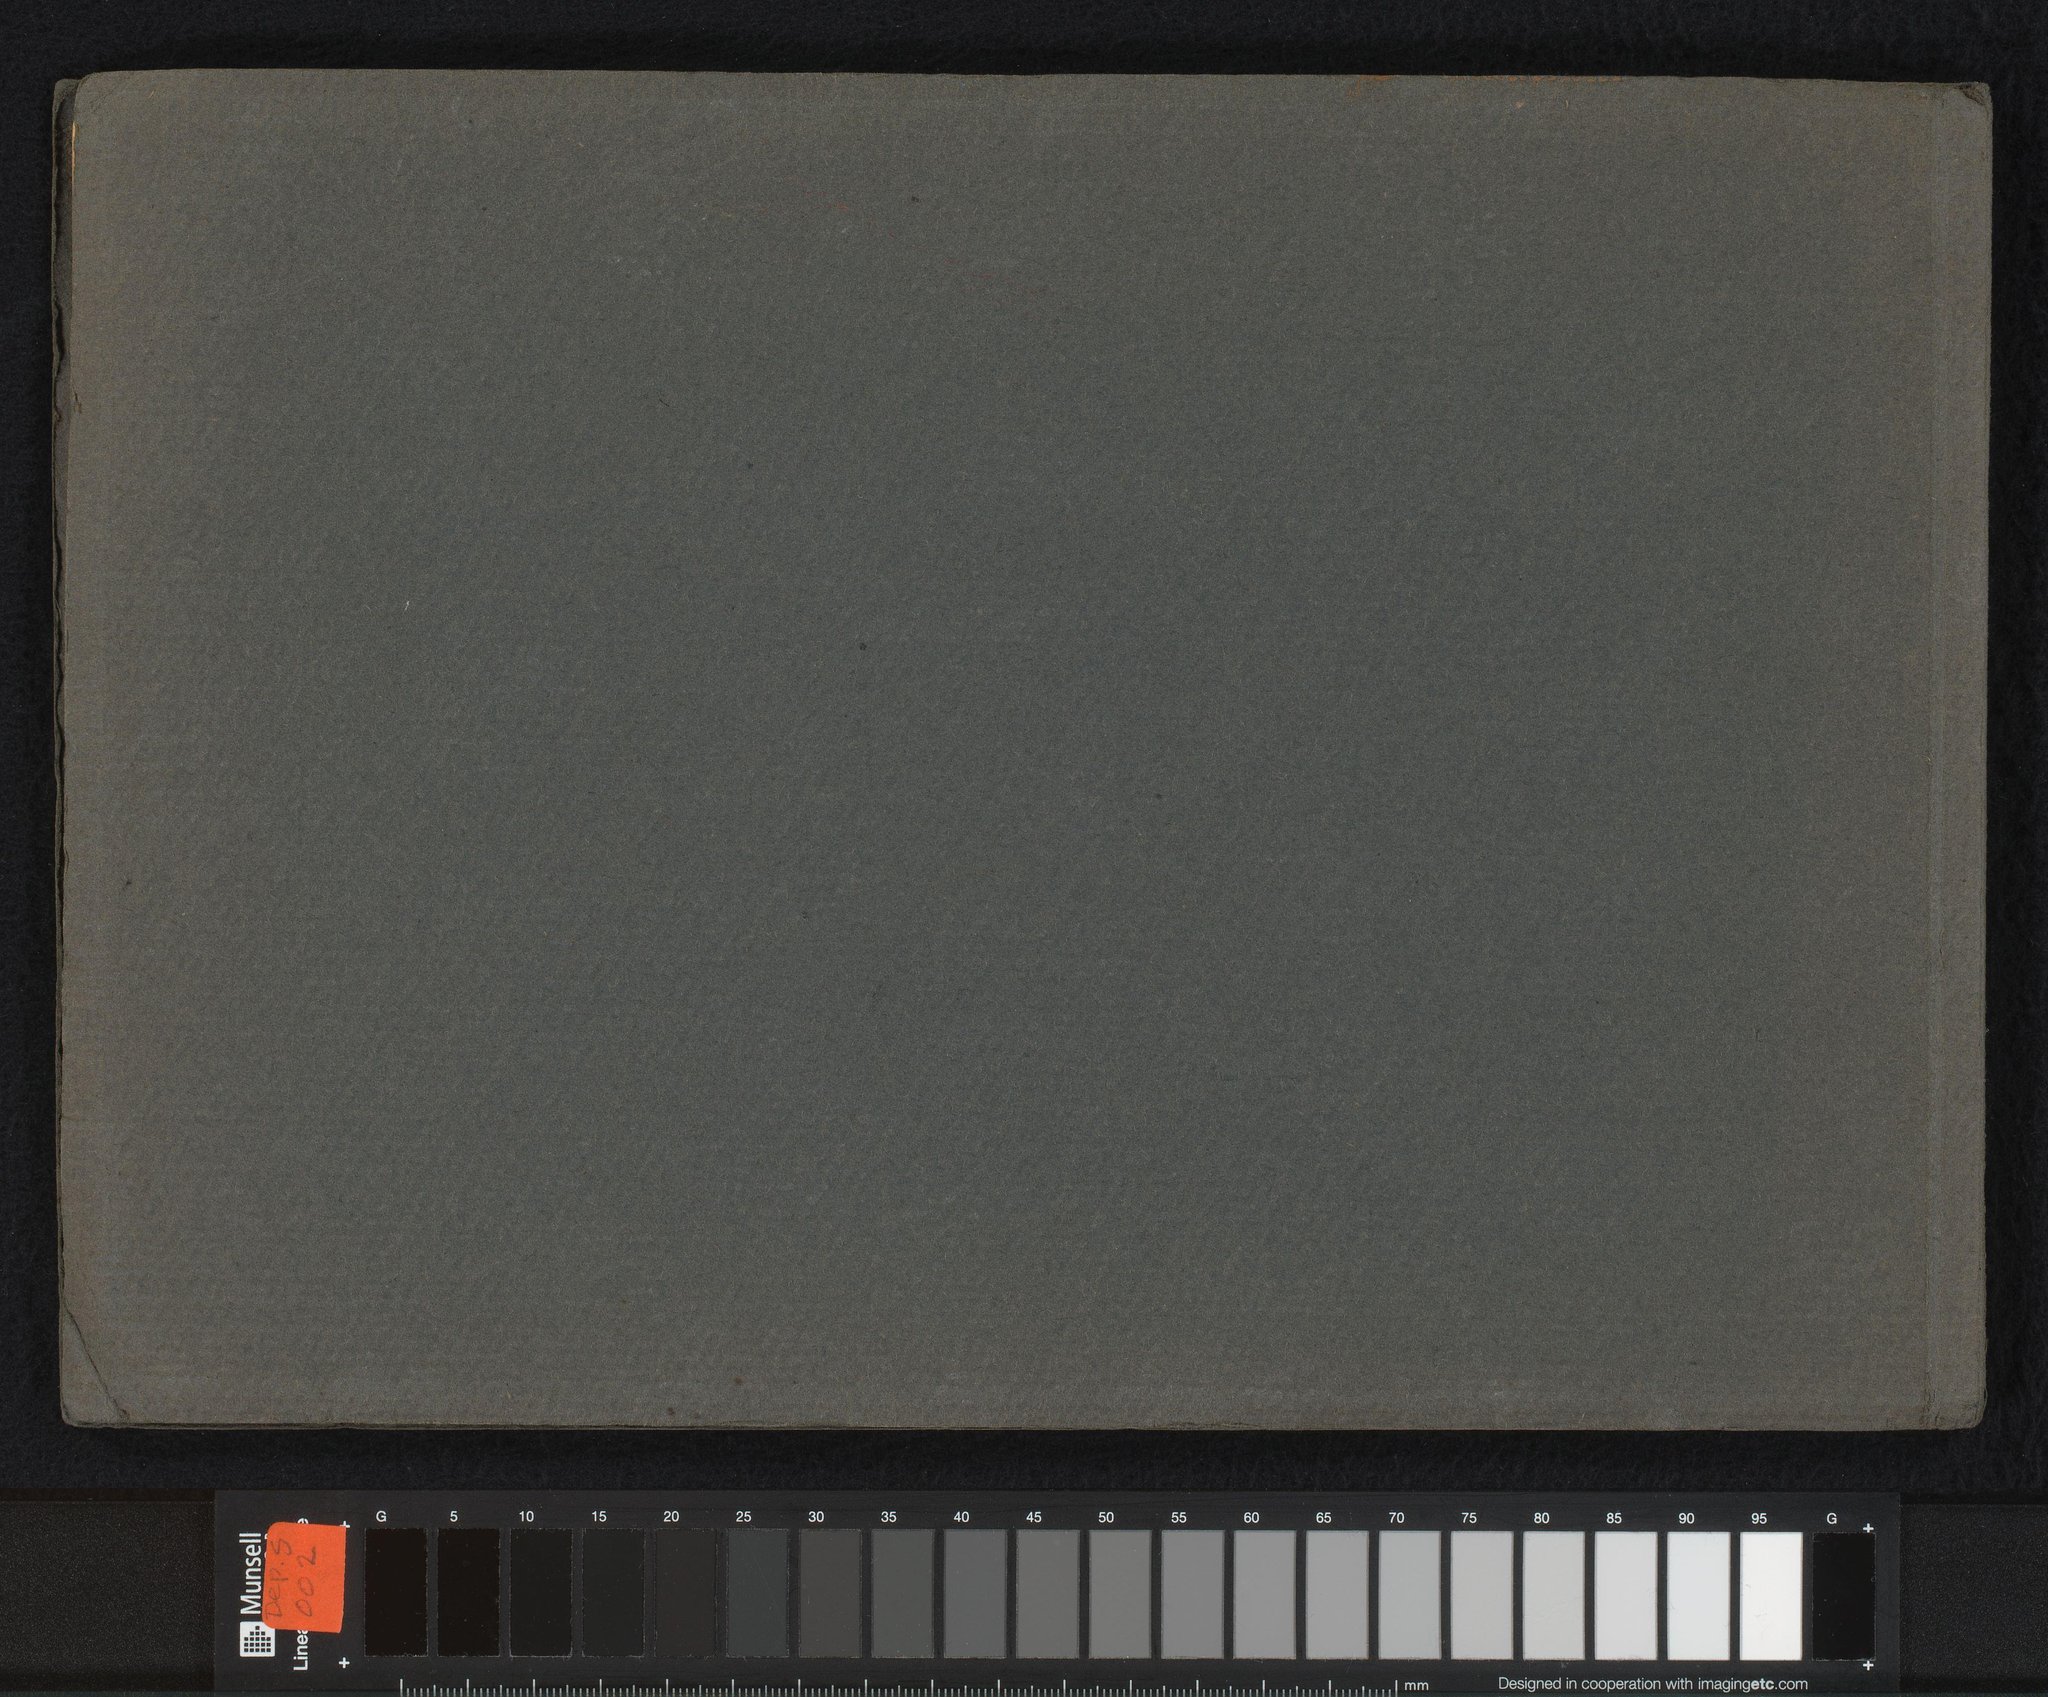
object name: album leaf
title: Vlissingen - de mailboot Prinses Juliana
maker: Anonymous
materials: paper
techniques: rotogravure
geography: flushing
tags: harbour, postal service, steamship, motorship, flushing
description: Deze prent maakt deel uit van een album.